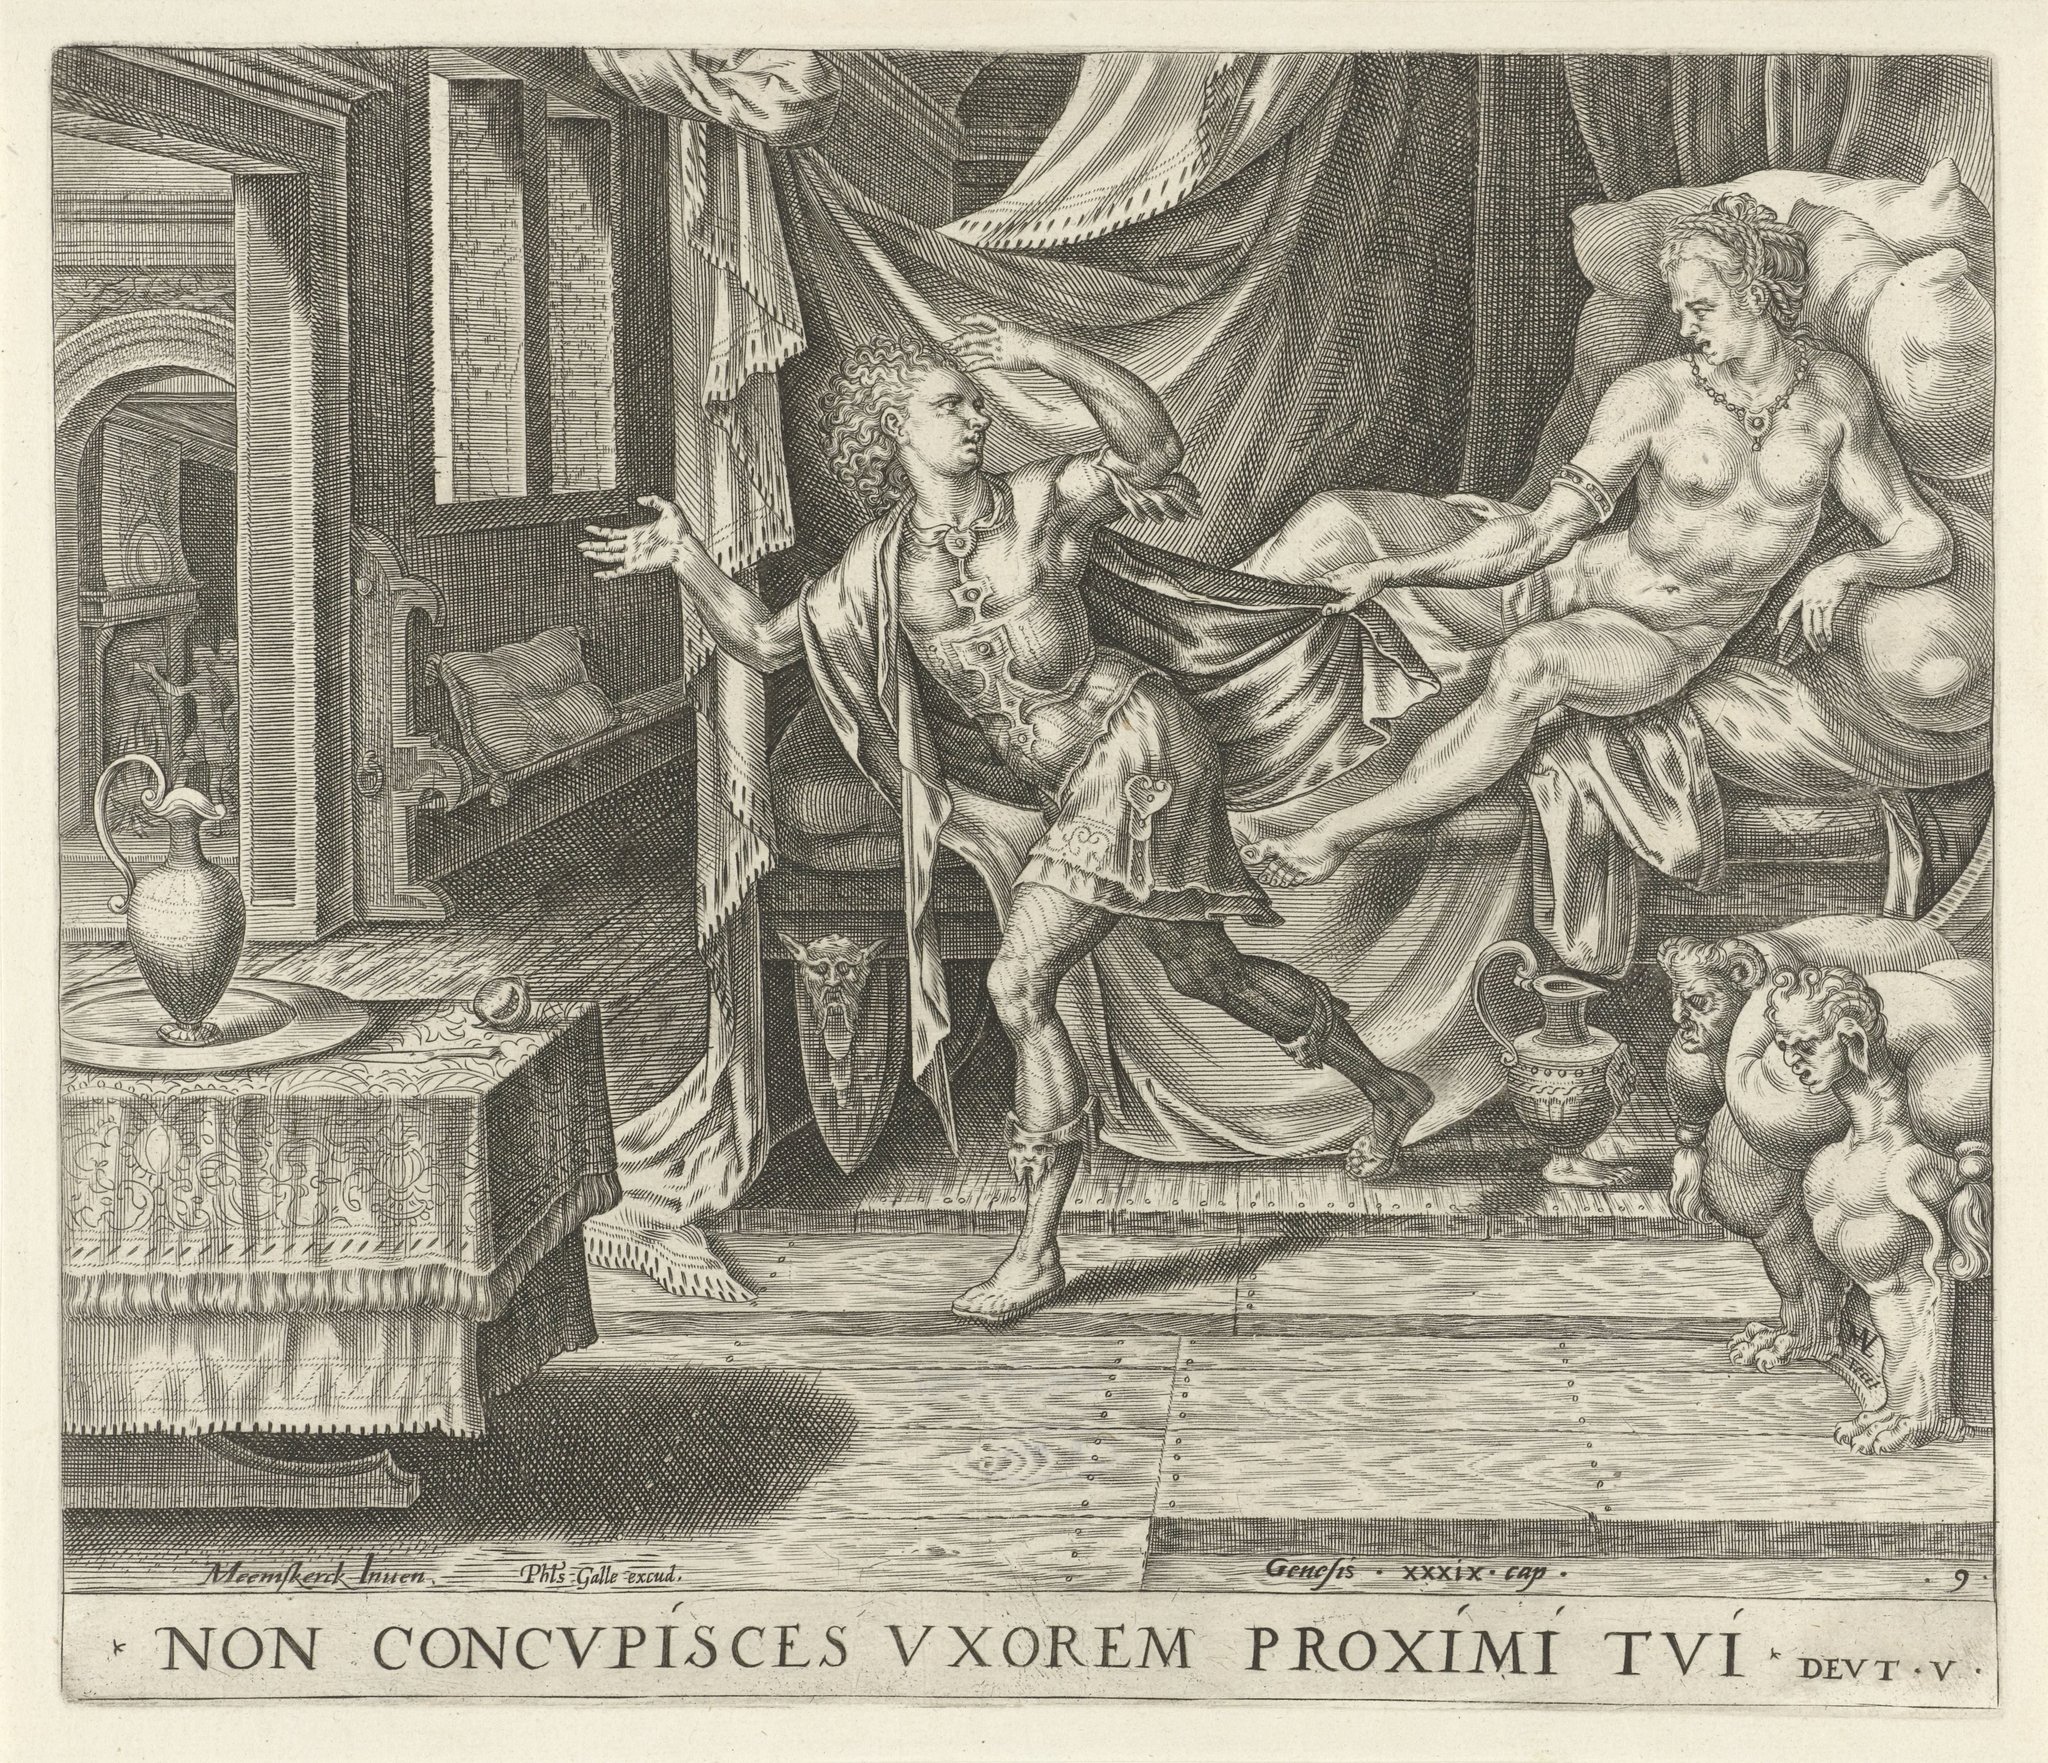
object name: print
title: Gij zult niet begeren de vrouw van uw naaste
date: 1570-1612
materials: paper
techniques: engraving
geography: amsterdam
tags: potiphar's wife catches joseph by his robe, usually while lying in bed; joseph escapes leaving his cloak behind in her hands (possibly with a naked child lying in a crib), 'you shall not covet' ~ separate representation of the tenth of the ten commandments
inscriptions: collector's mark: Lugt 2228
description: Jozef vlucht voor de vrouw van Potifar, die naakt op haar bed ligt. Zij grijpt zijn kleed vast. Prent maakt deel uit van een serie over de tien geboden en geeft een illustratie van het negende gebod weer: Gij zult niet begeren de vrouw van uw naaste. Onderaan in de marge een verwijzing naar de Bijbeltekst in het Latijn.